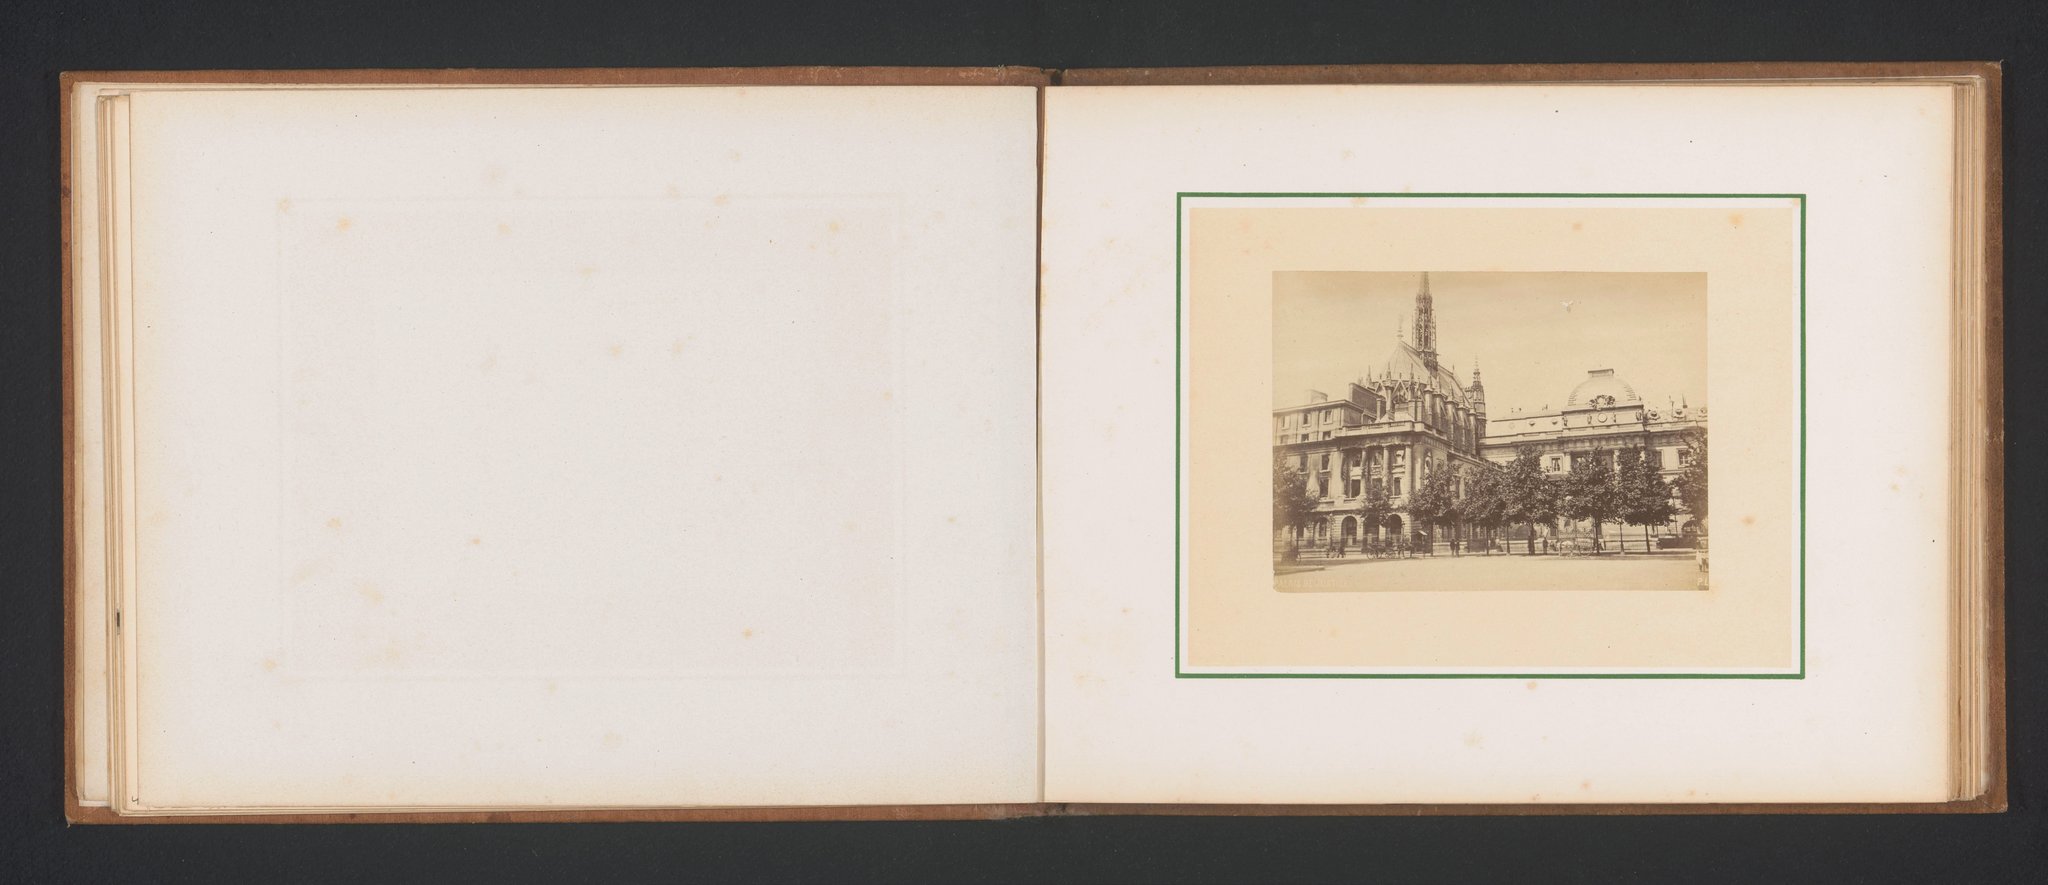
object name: photograph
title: Palais de Justice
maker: p. loubère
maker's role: fotograaf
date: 1871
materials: photographic support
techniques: albumen print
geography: paris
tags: court building, ruin of a building ~ architecture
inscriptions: monogram: ‘P.L.’